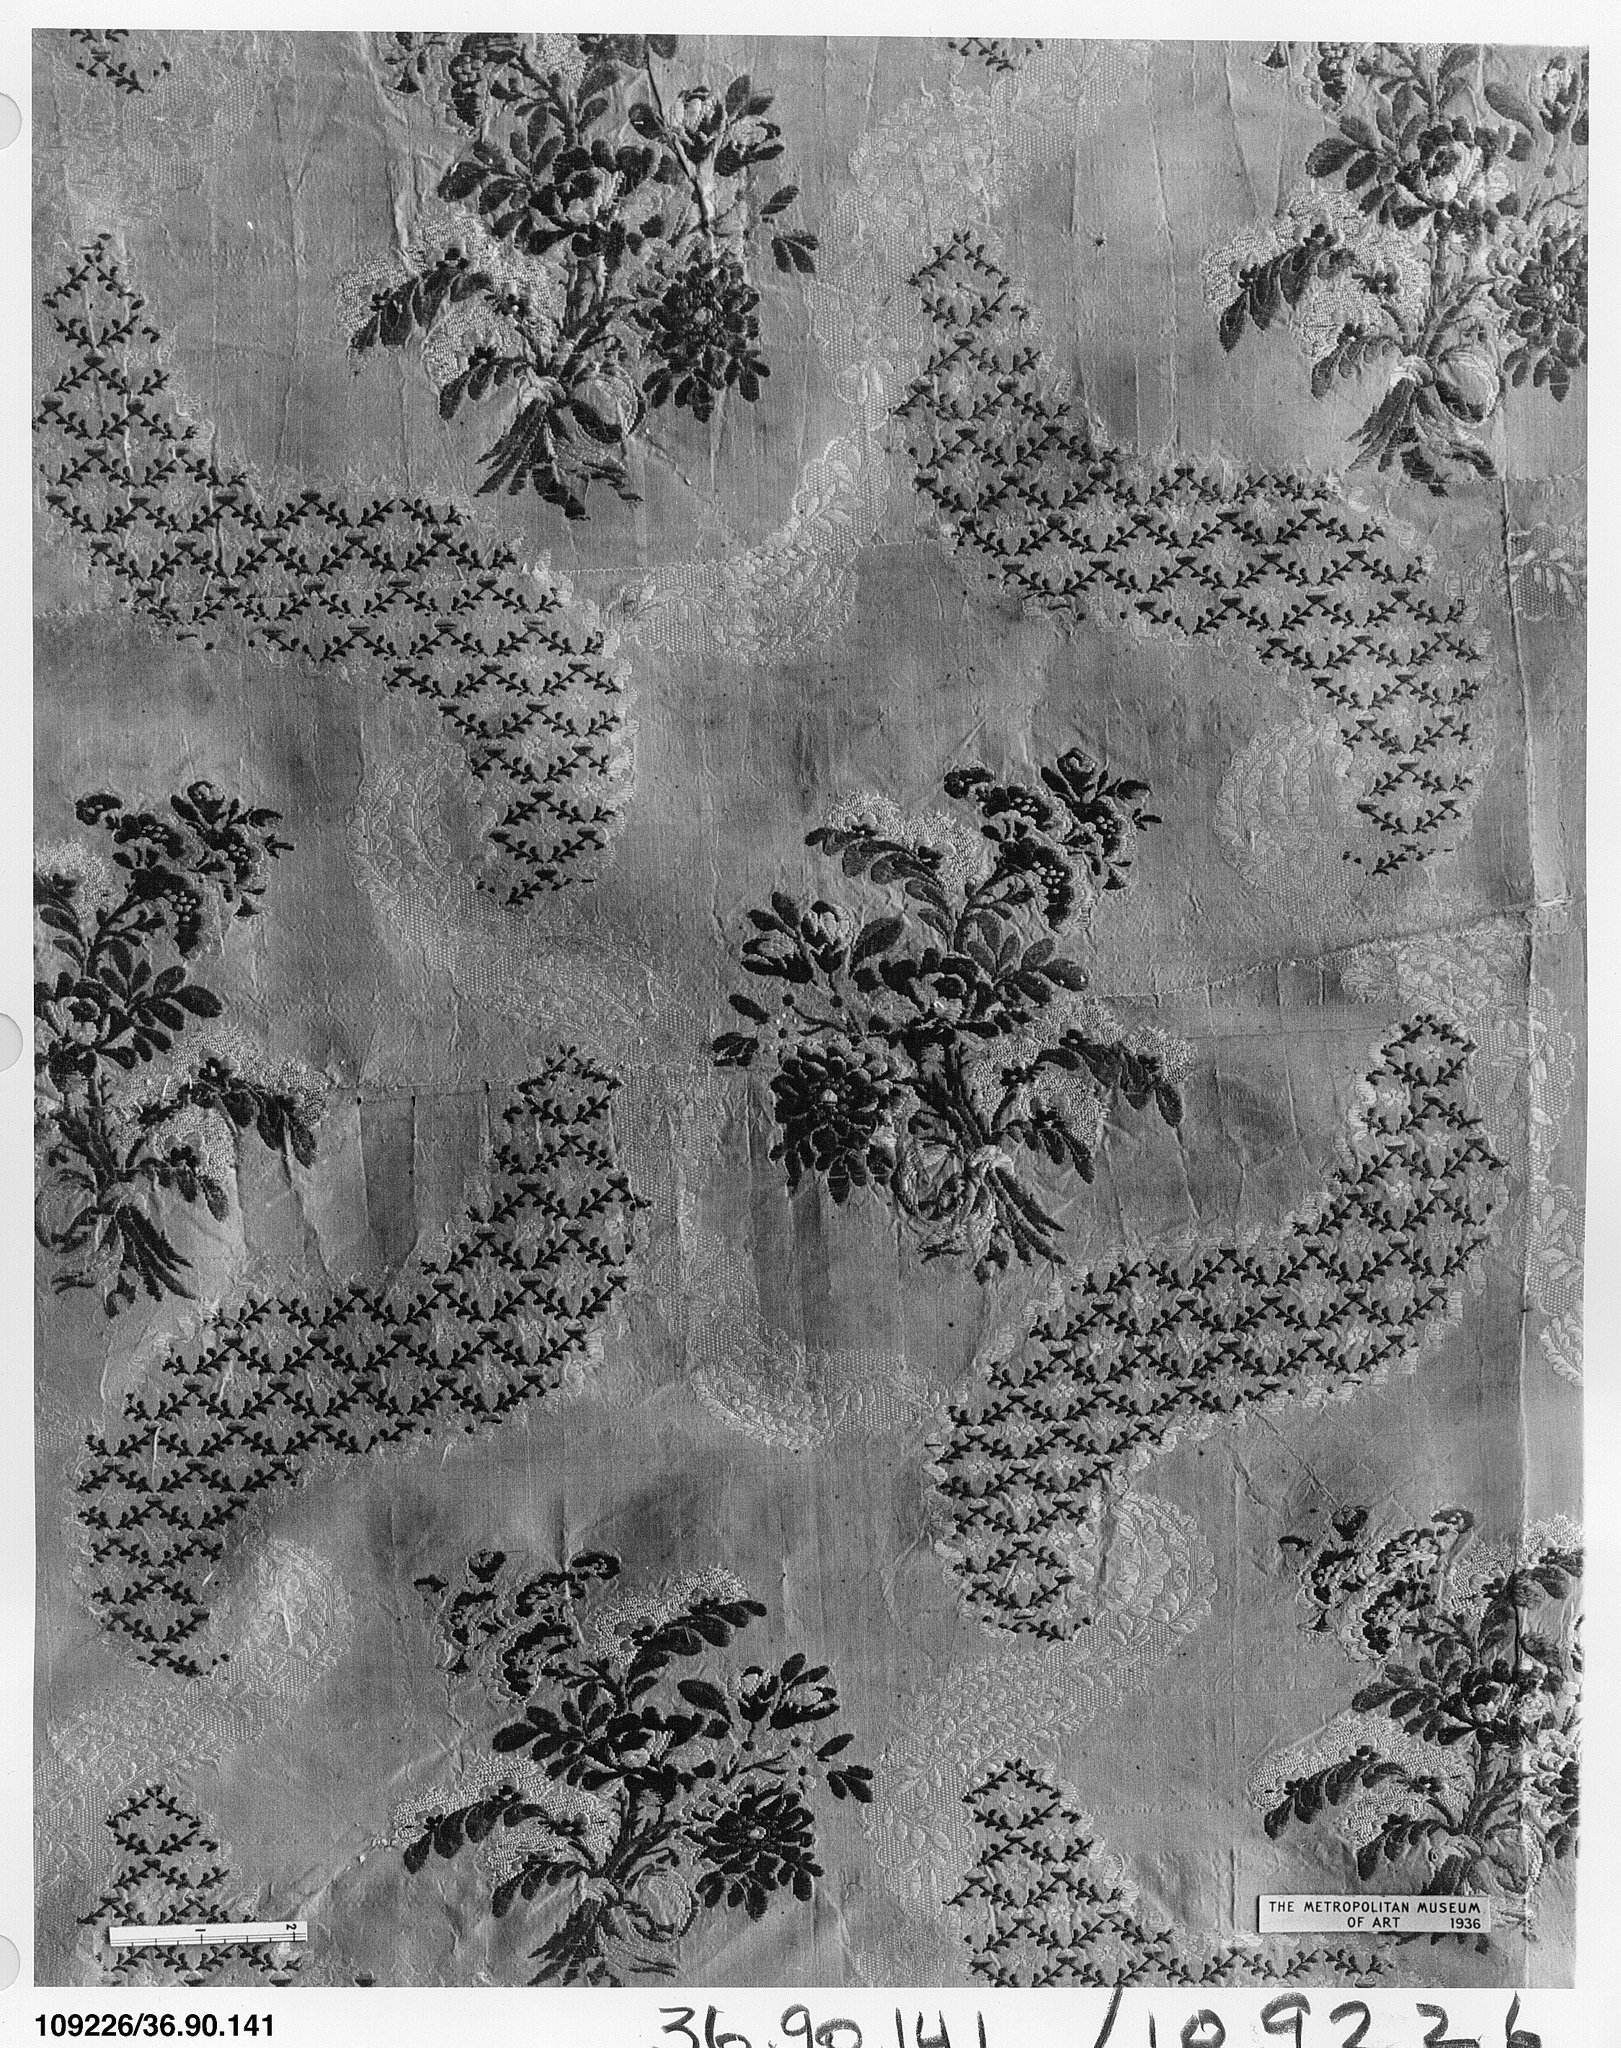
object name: piece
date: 1750-1760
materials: silk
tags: flowers,leaves